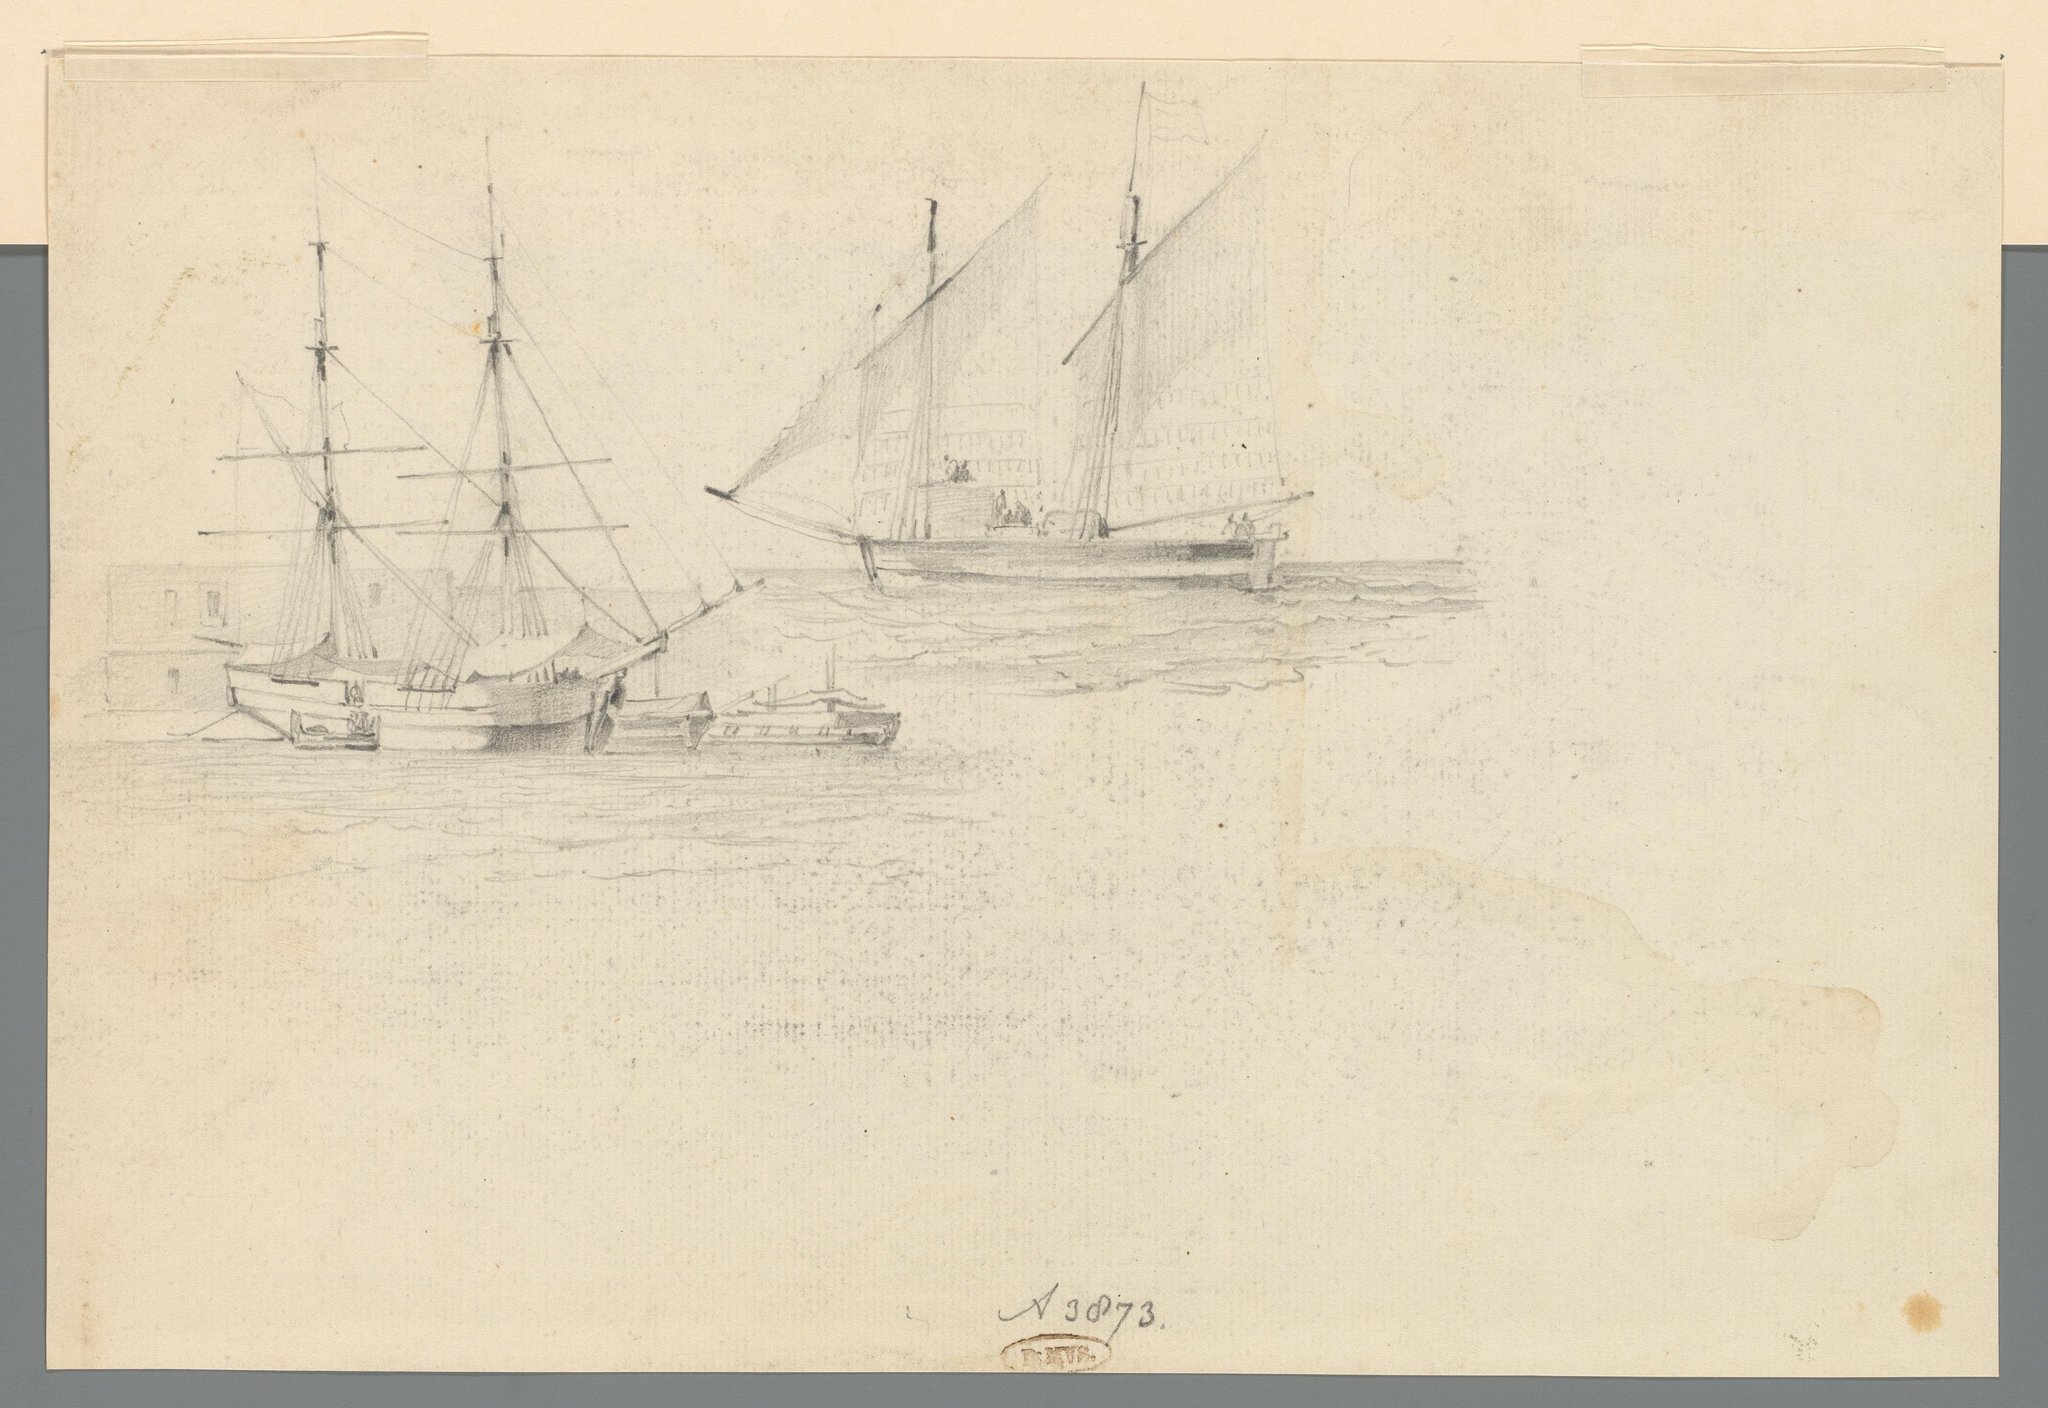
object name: drawing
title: Studies van zeilschepen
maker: willem anthonie van deventer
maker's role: draughtsman, painter, print maker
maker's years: 1824-1893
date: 1834-1893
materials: paper, pencil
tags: sailing-ship, sailing-boat